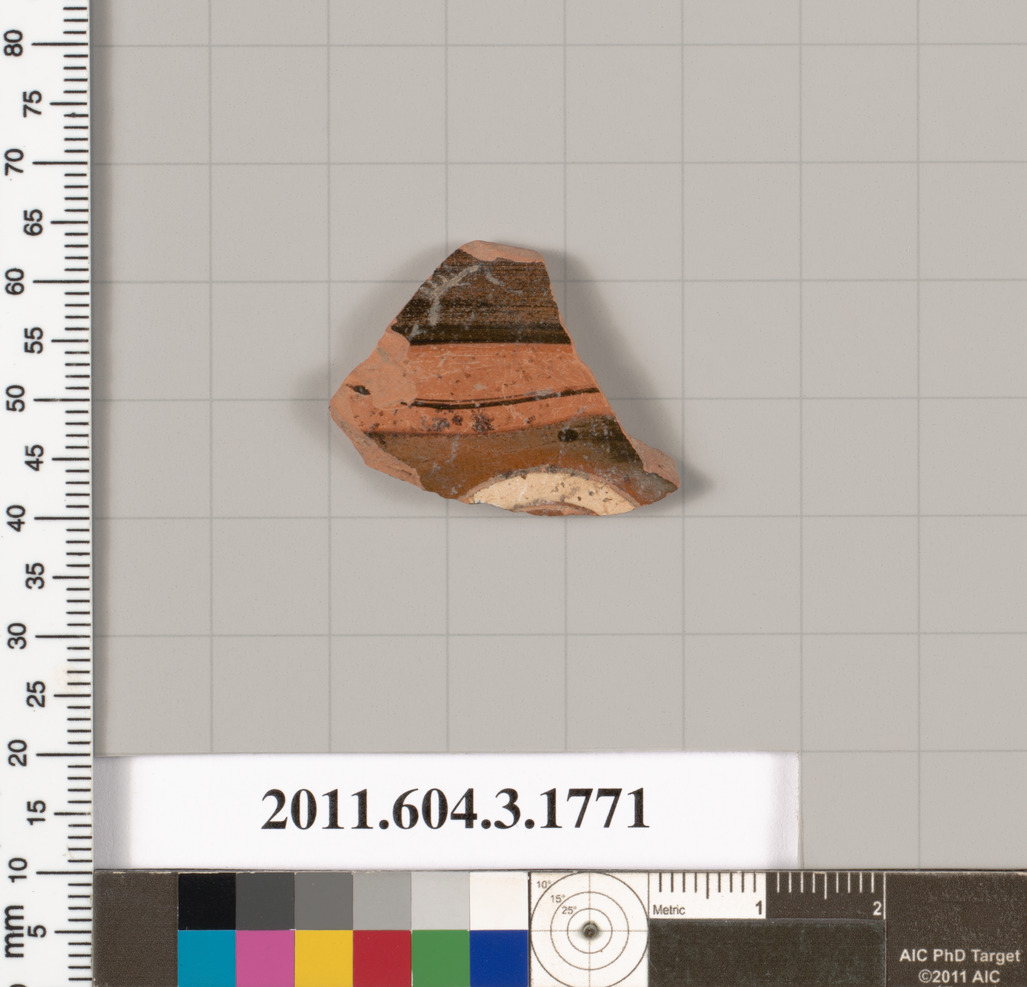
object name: kylix fragment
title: Terracotta fragment of a kylix: Band cup (drinking cup)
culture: greek, attic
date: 520-510 BCE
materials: terracotta